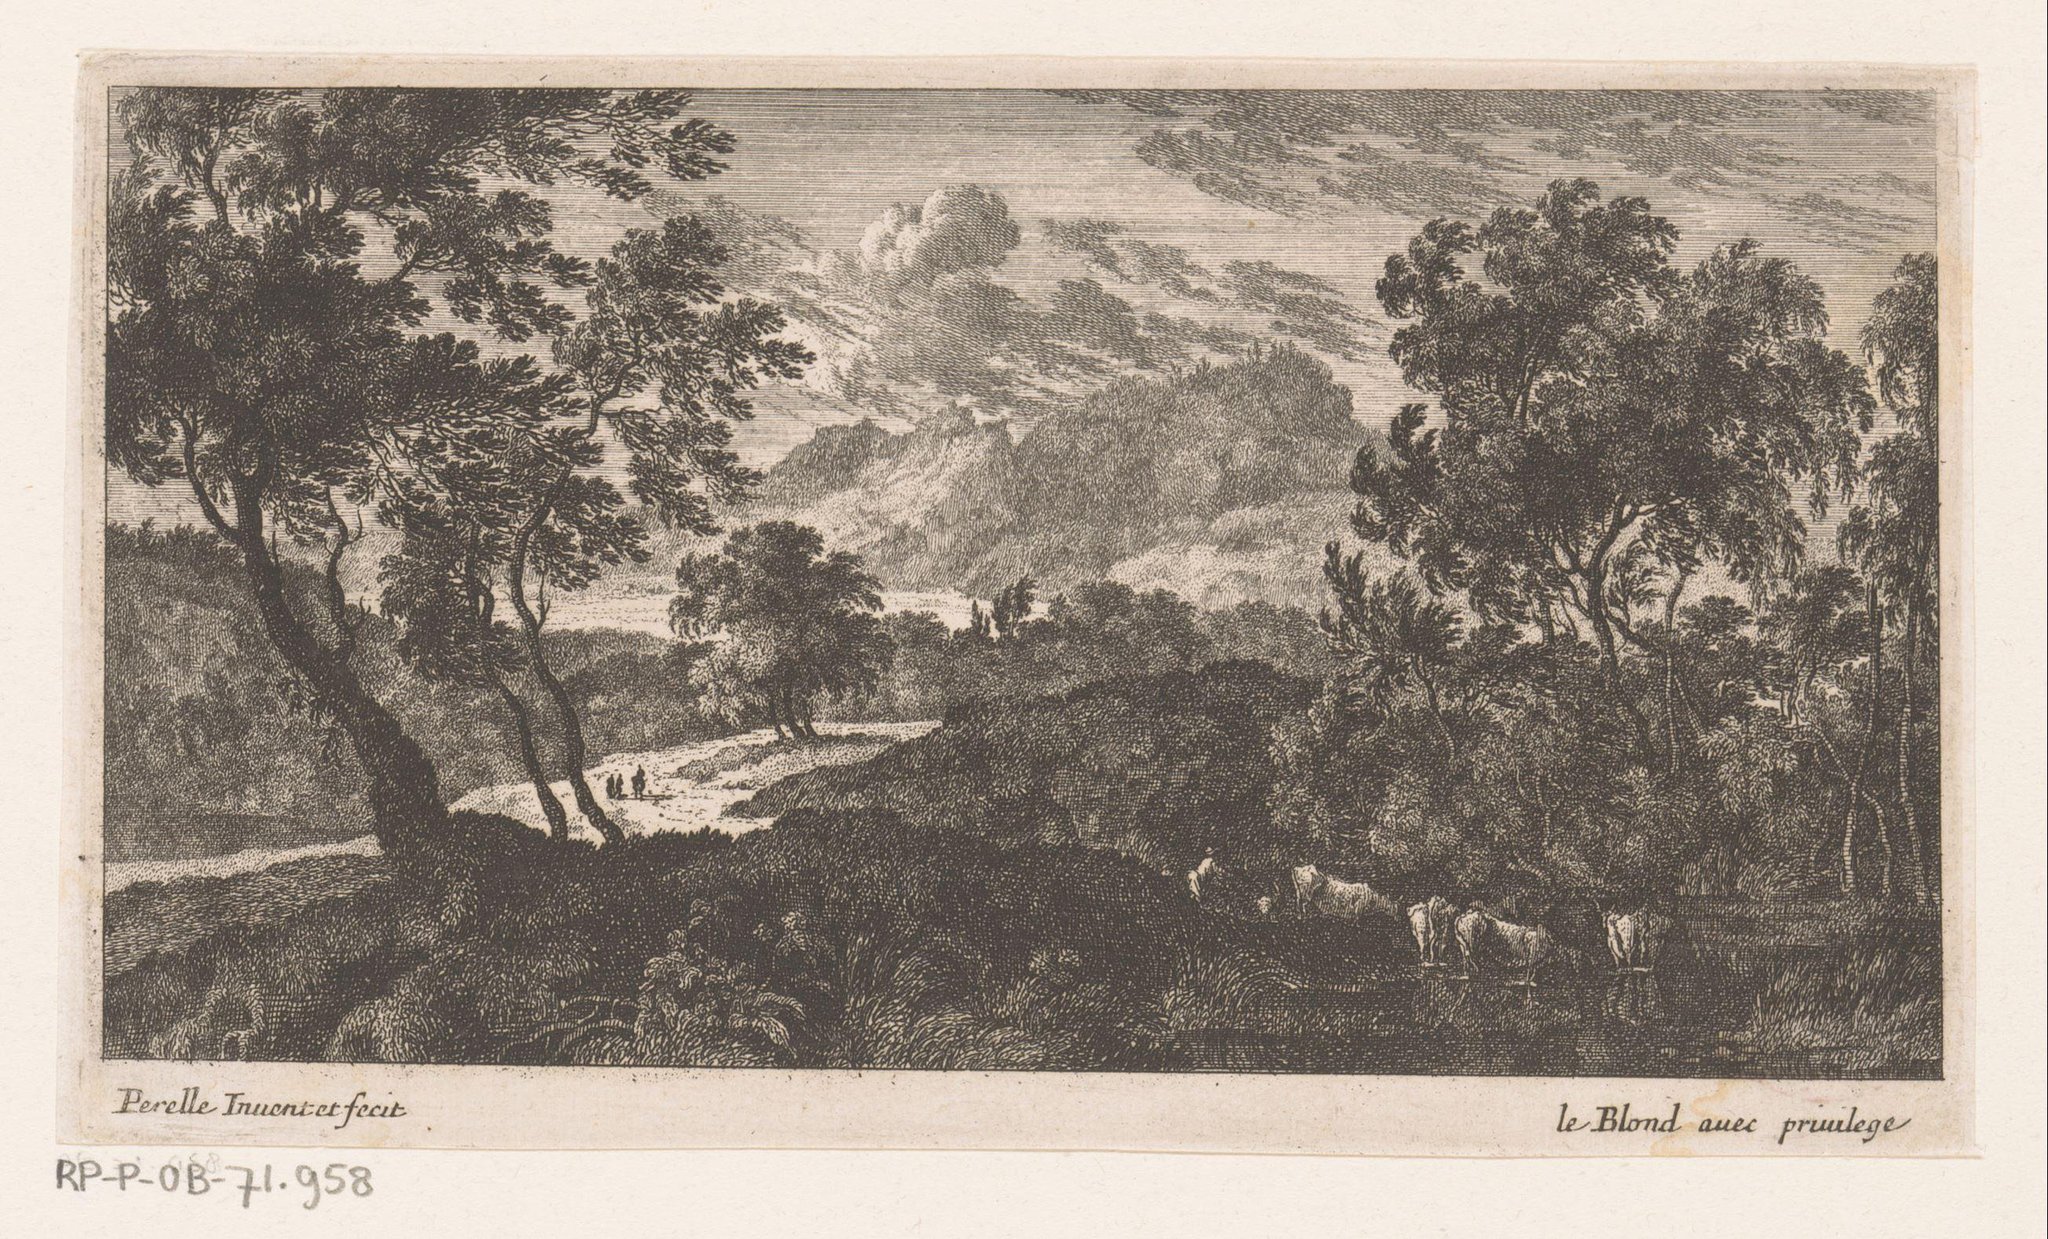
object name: print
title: Landschap met rechts drinkende runderen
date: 1613-1666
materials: paper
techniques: etching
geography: paris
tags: water course, herd, flock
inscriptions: collector's mark: Lugt 240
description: Prenten met het signatuur 'Perelle' kunnen zowel door vader Gabriel als door zonen Nicolas en Adam gemaakt zijn.